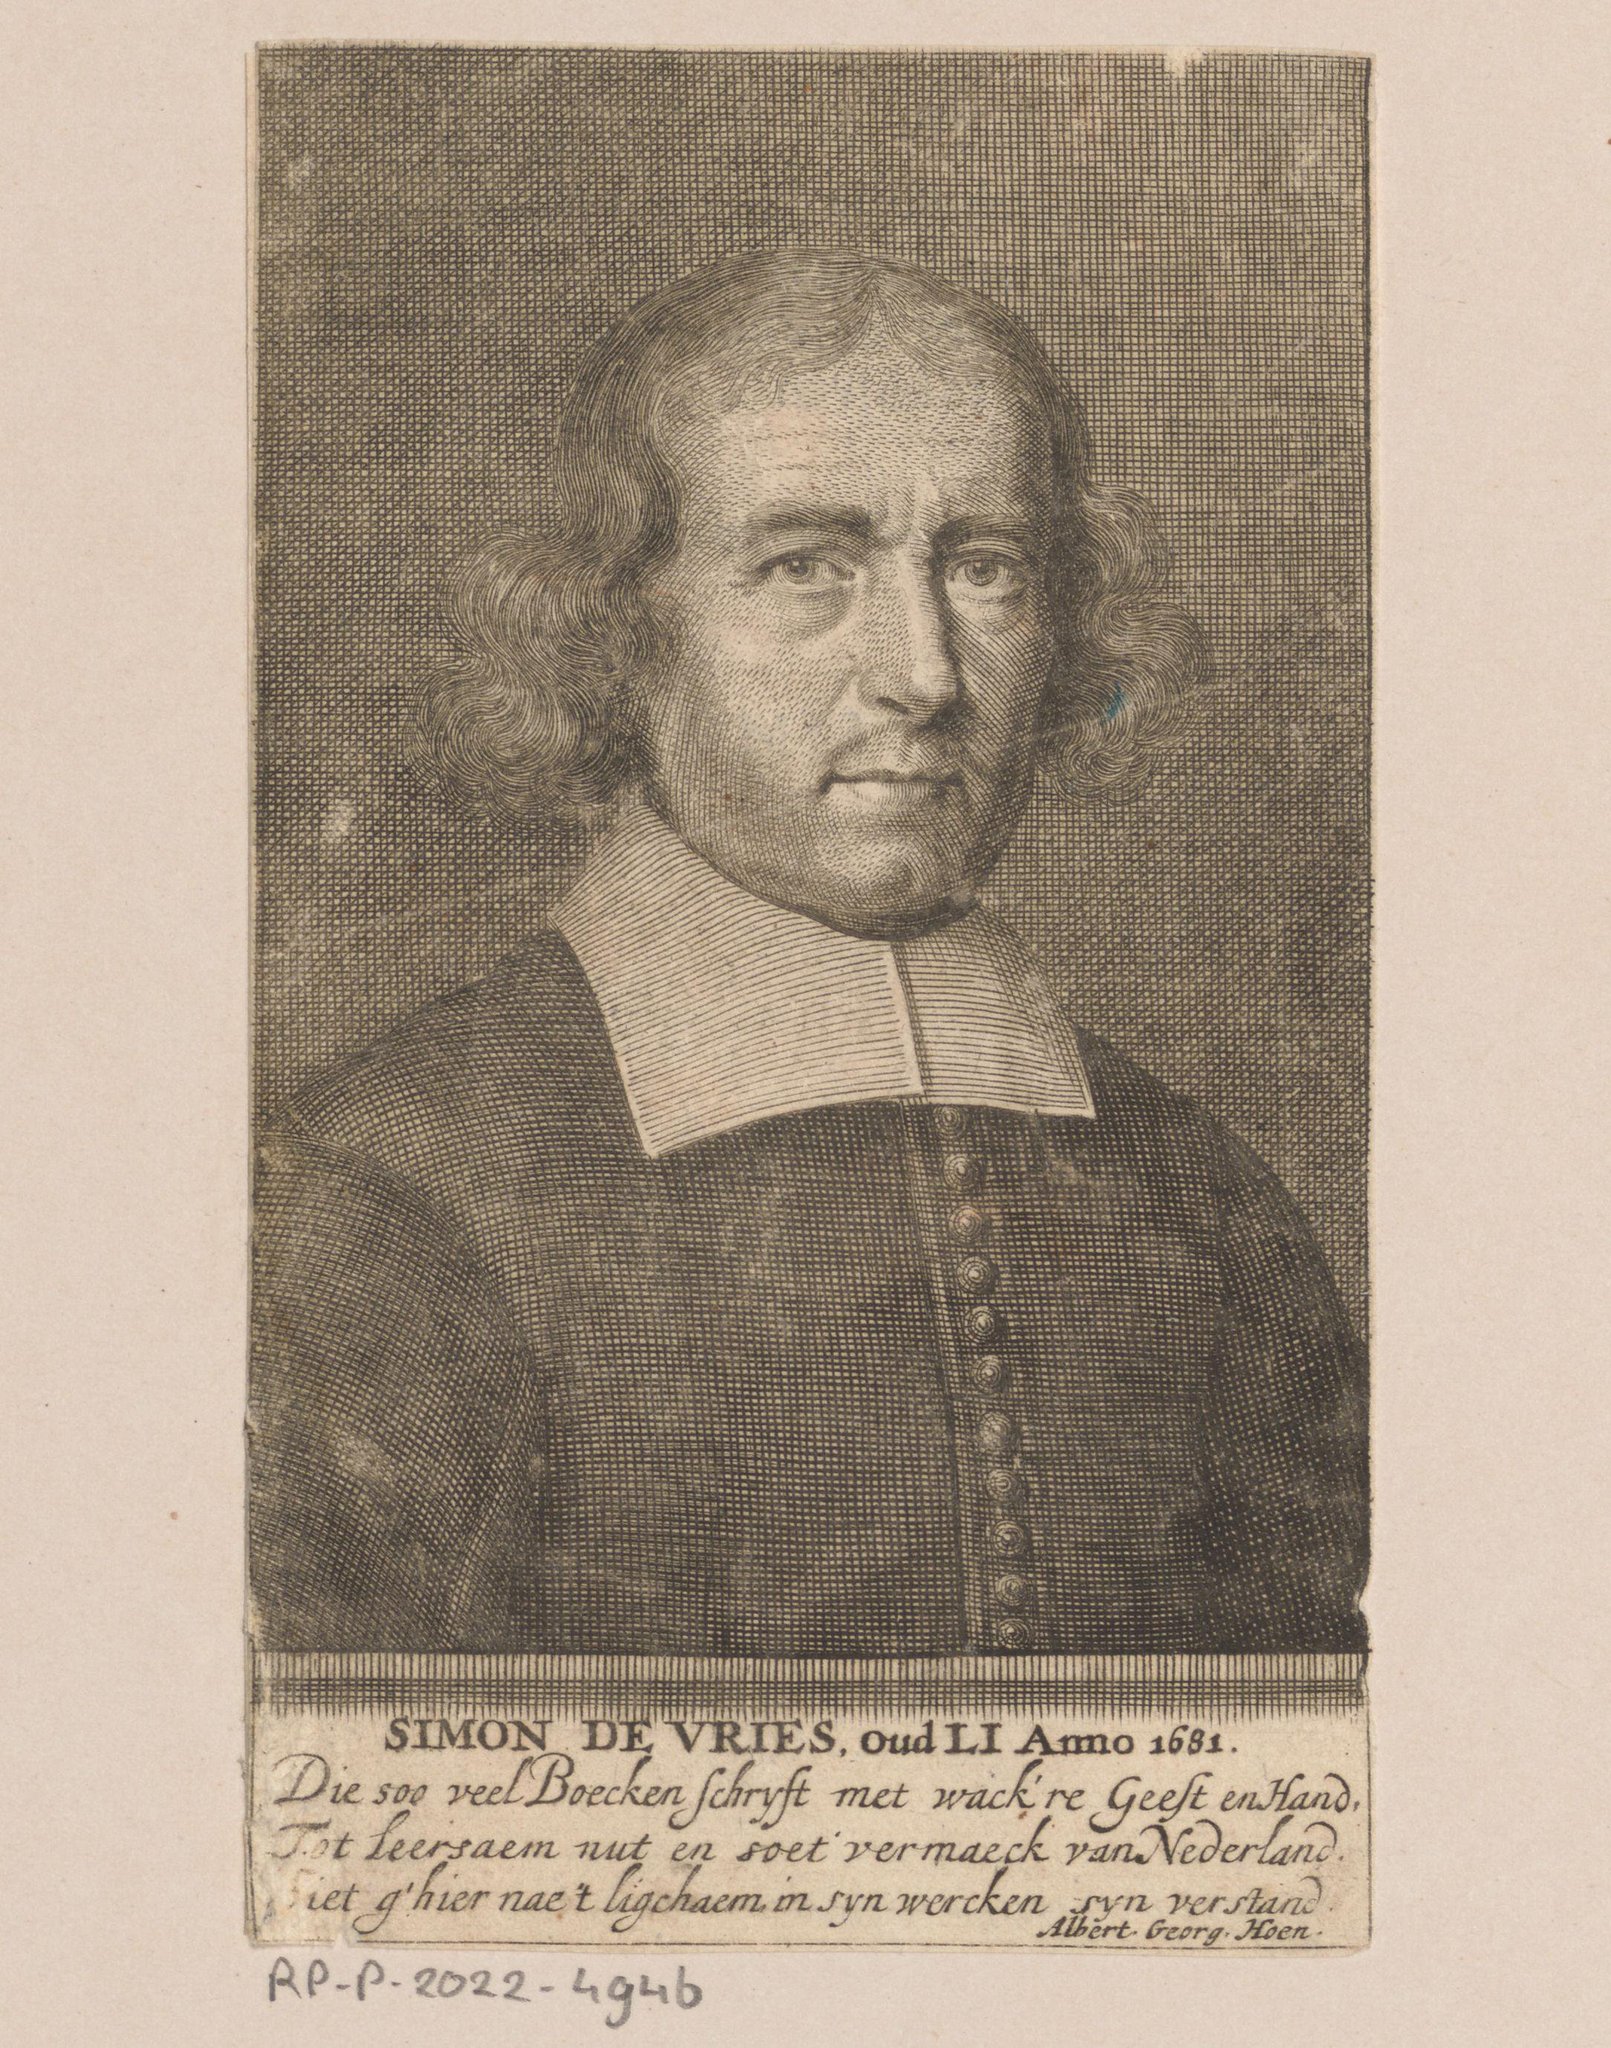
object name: print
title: Portret van Simon de Vries op 51-jarige leeftijd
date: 1681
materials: paper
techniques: engraving, letterpress printing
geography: northern netherlands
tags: simon de vries, historical persons, portrait of a writer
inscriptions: signature: ‘Albert Georg Hoen’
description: Prent uit: Vries, Simon de. D'eedelste tijdkortingh der weet-geerige verstanden (...). Amsterdam: Jan Bouman, 1682.